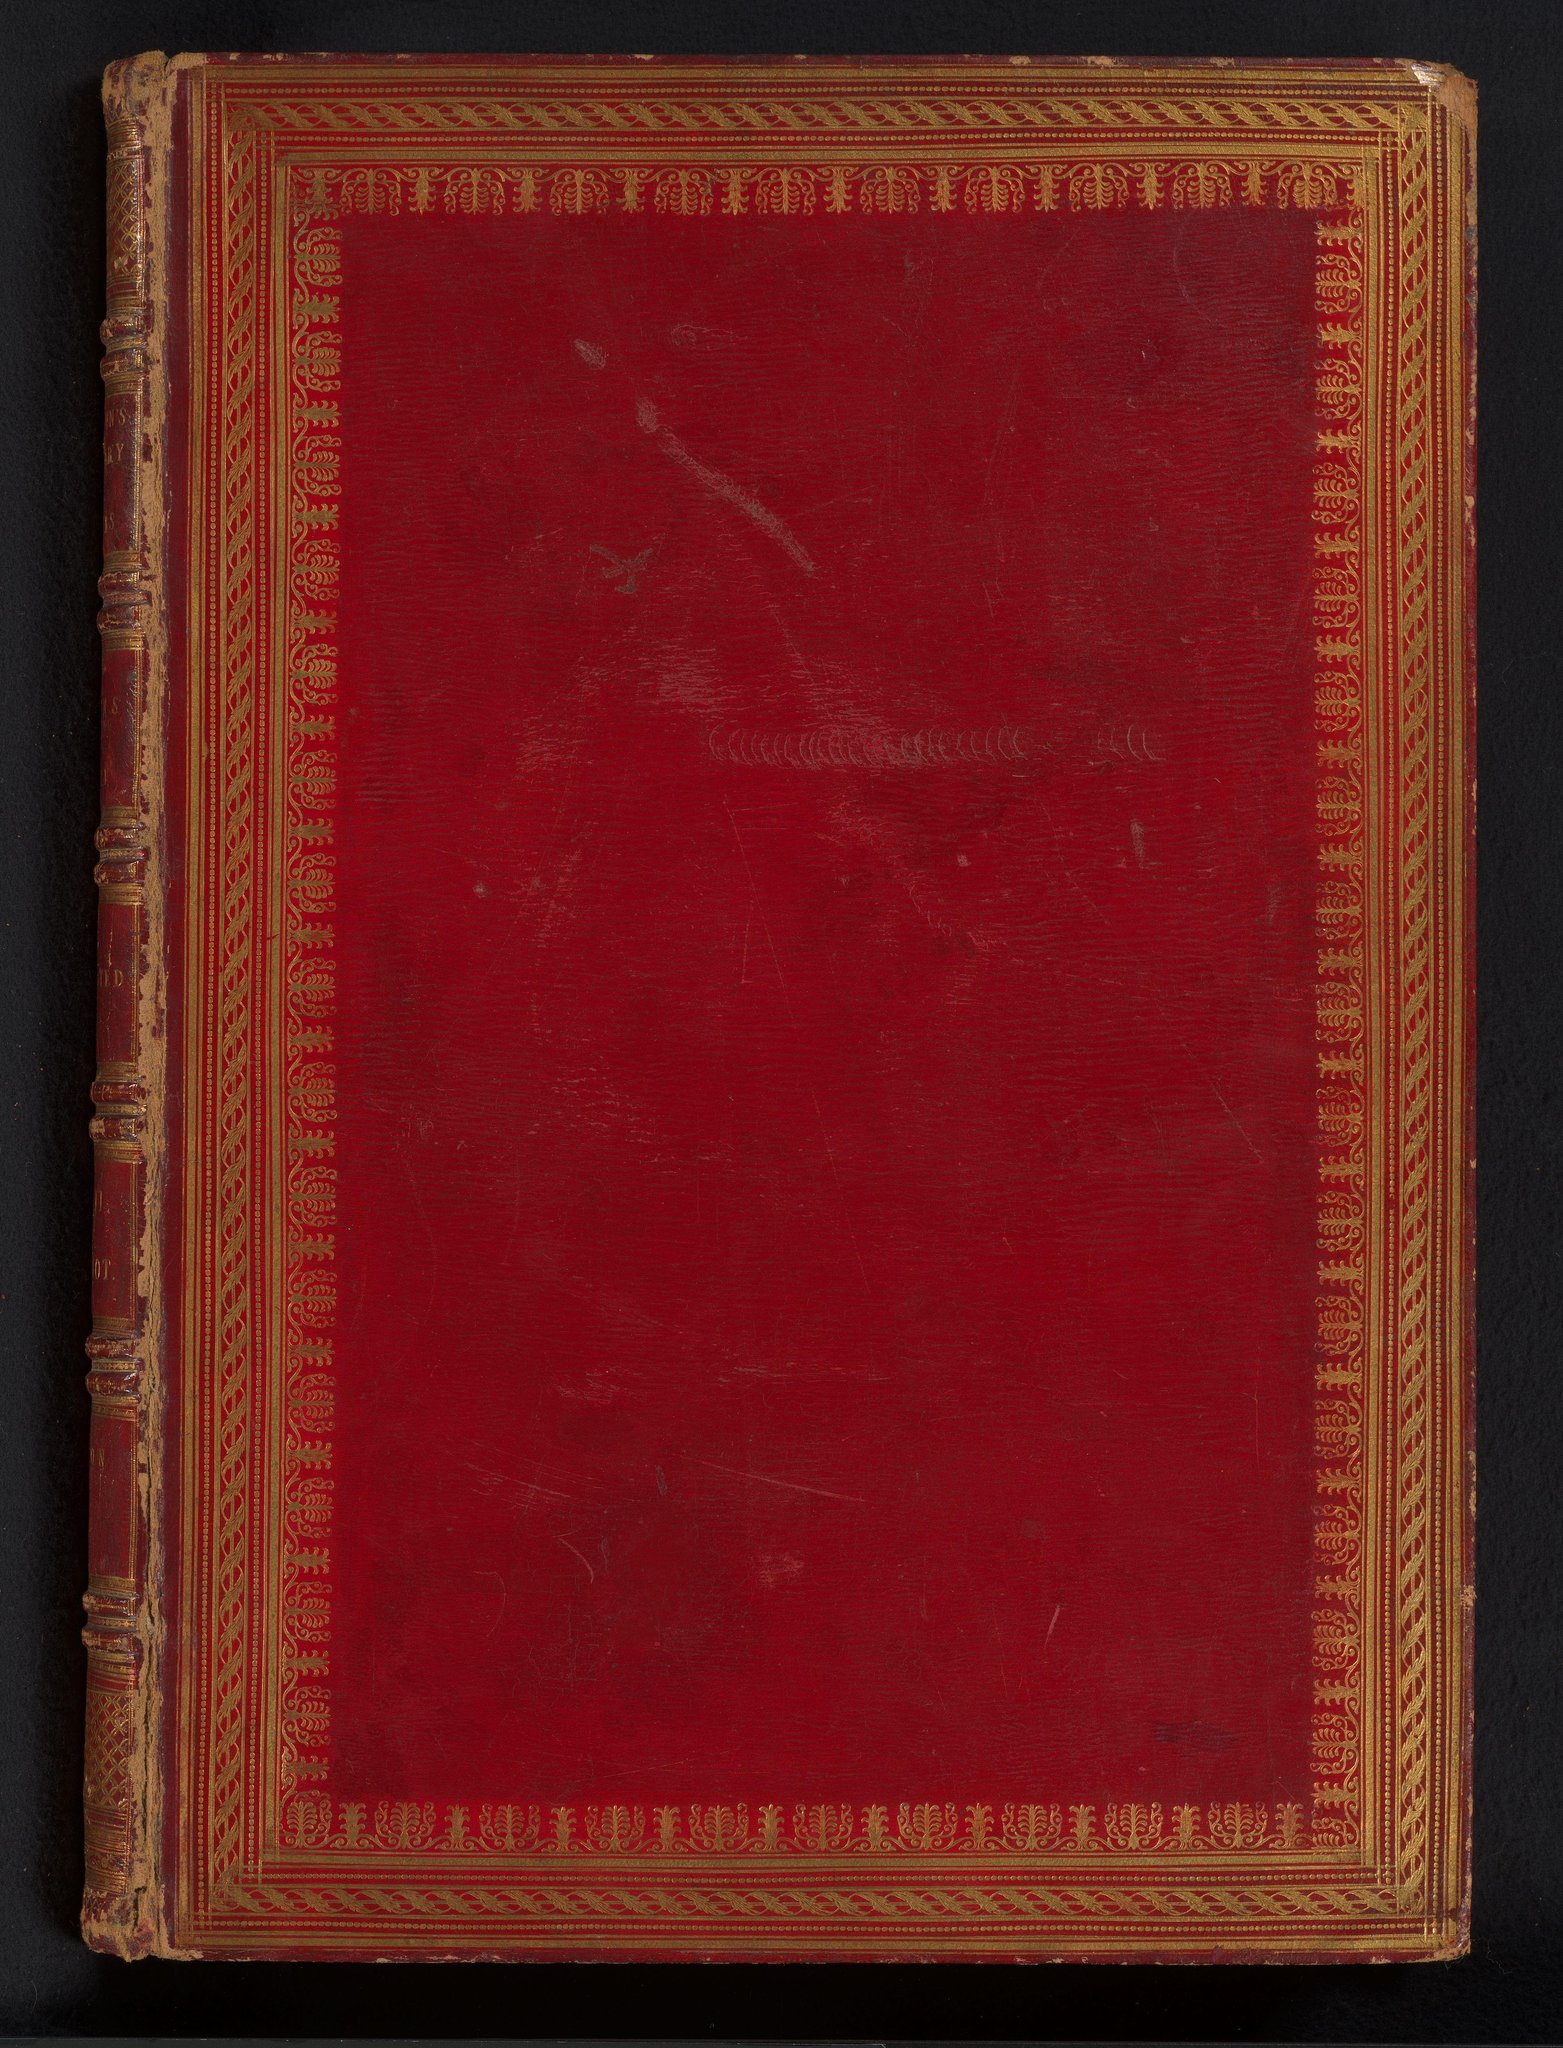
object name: prentrecueil, prentenalbum, prentalbum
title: Album met voorstellingen van en door kunstenaars genoemd in het lexicon 'Pilkington's Dictionary of Painters'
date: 1805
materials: cardboard, leather, paper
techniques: bookbinding, printing, engraving, etching, letterpress printing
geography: london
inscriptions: : ‘7’, number: ‘2451/ 4jul’, number, : ‘Con.pp/ 137 mounted engr/ etched portrs/ plates’, : ‘B’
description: Factice album met 132 prenten en één titelpagina op 80 albumbladen. Factice album, dat wil zeggen: een door een verzamelaar of eigenaar van de prenten samengesteld album. Dit verzamelde werk is gebonden in vier banden, met deze boekband als tweede deel. Het album is samengesteld met de publicatie van een kunstenaars encyclopedie geschreven door Matthew Pilkington in 1767, bewerkt en herzien door Johann Heinrich Füssli in1805, als leidraad voor de verzamelde prenten. De afgesneden tekstbladen uit dit boek zijn, met de albumbladen als passe-partouts, in het album verwerkt. De randen van pagina's 173 tot 352 van het tweede deel zijn op deze wijze in dit album geplakt. Er staat tekst in het Engels op beide zijden, die door deze methode zichtbaar blijft. De prenten zijn los op de albumbladen geplakt of op de folio's gedrukt en ingevoegd. De prenten zijn hoofdzakelijk gemaakt door de kunstenaars beschreven in de ingevoegde tekst op het naastgelegen albumblad. De prenten zijn een aanvulling op de tekst. Het zijn hoofdzakelijk portretten van de genoemde kunstenaars, alfabetisch op achternaam, en prenten met ontwerpen door deze kunstenaars.